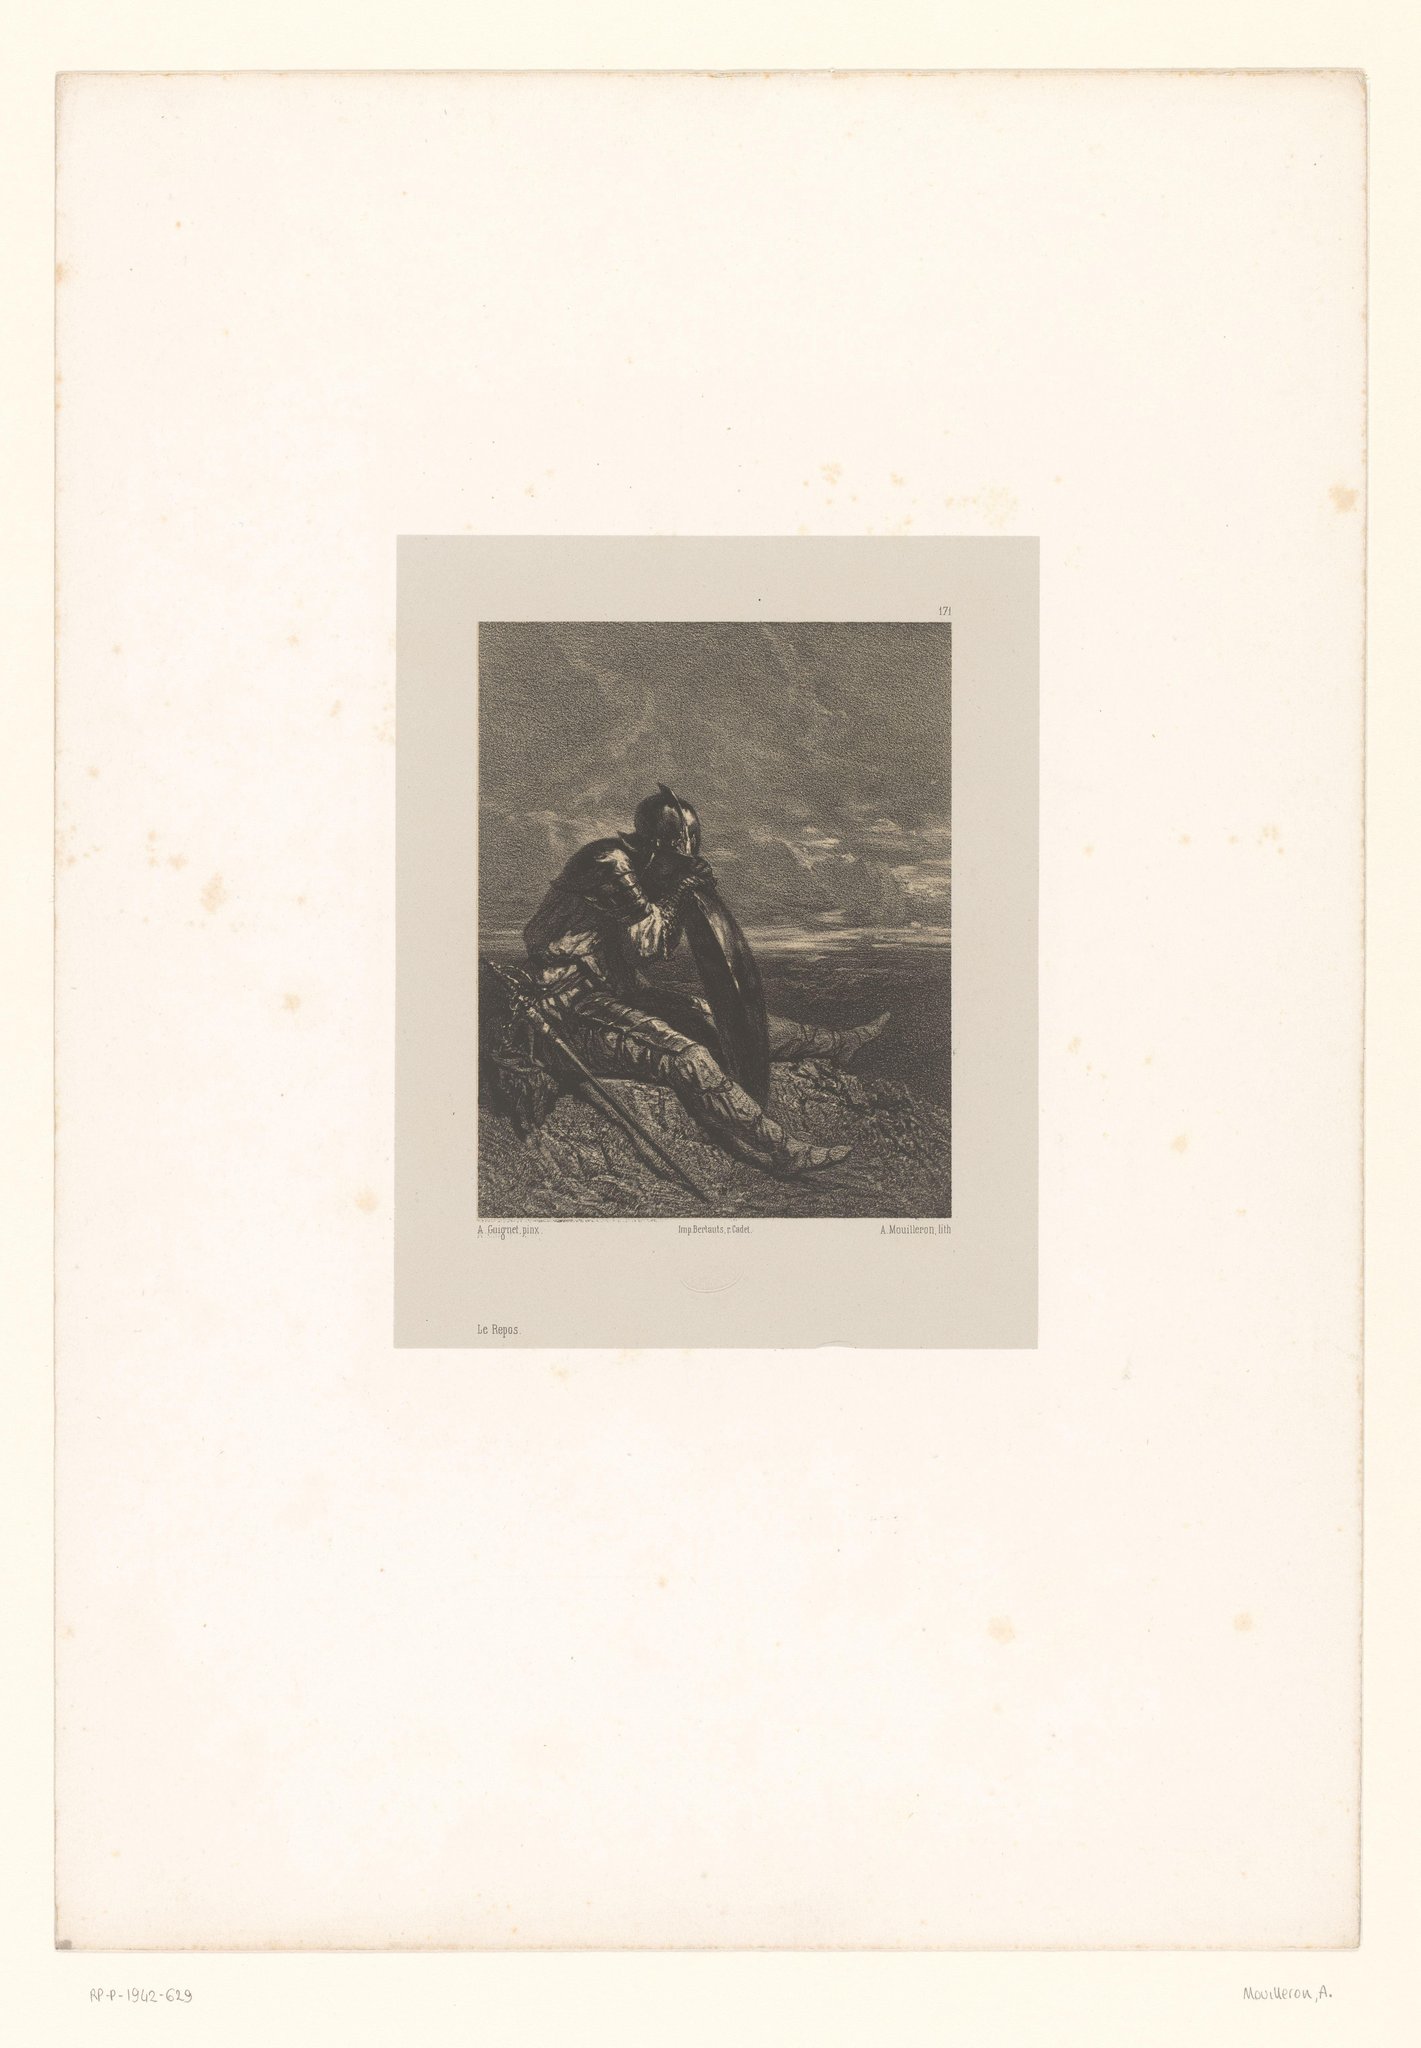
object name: print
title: Oude en hedendaagse kunstenaars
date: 1851-1862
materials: paper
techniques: lithograph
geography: paris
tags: rock-formations - hh - ideal landscapes, the soldier; the soldier's life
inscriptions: check stamp: Lugt 36a, collector's mark: Lugt 2228